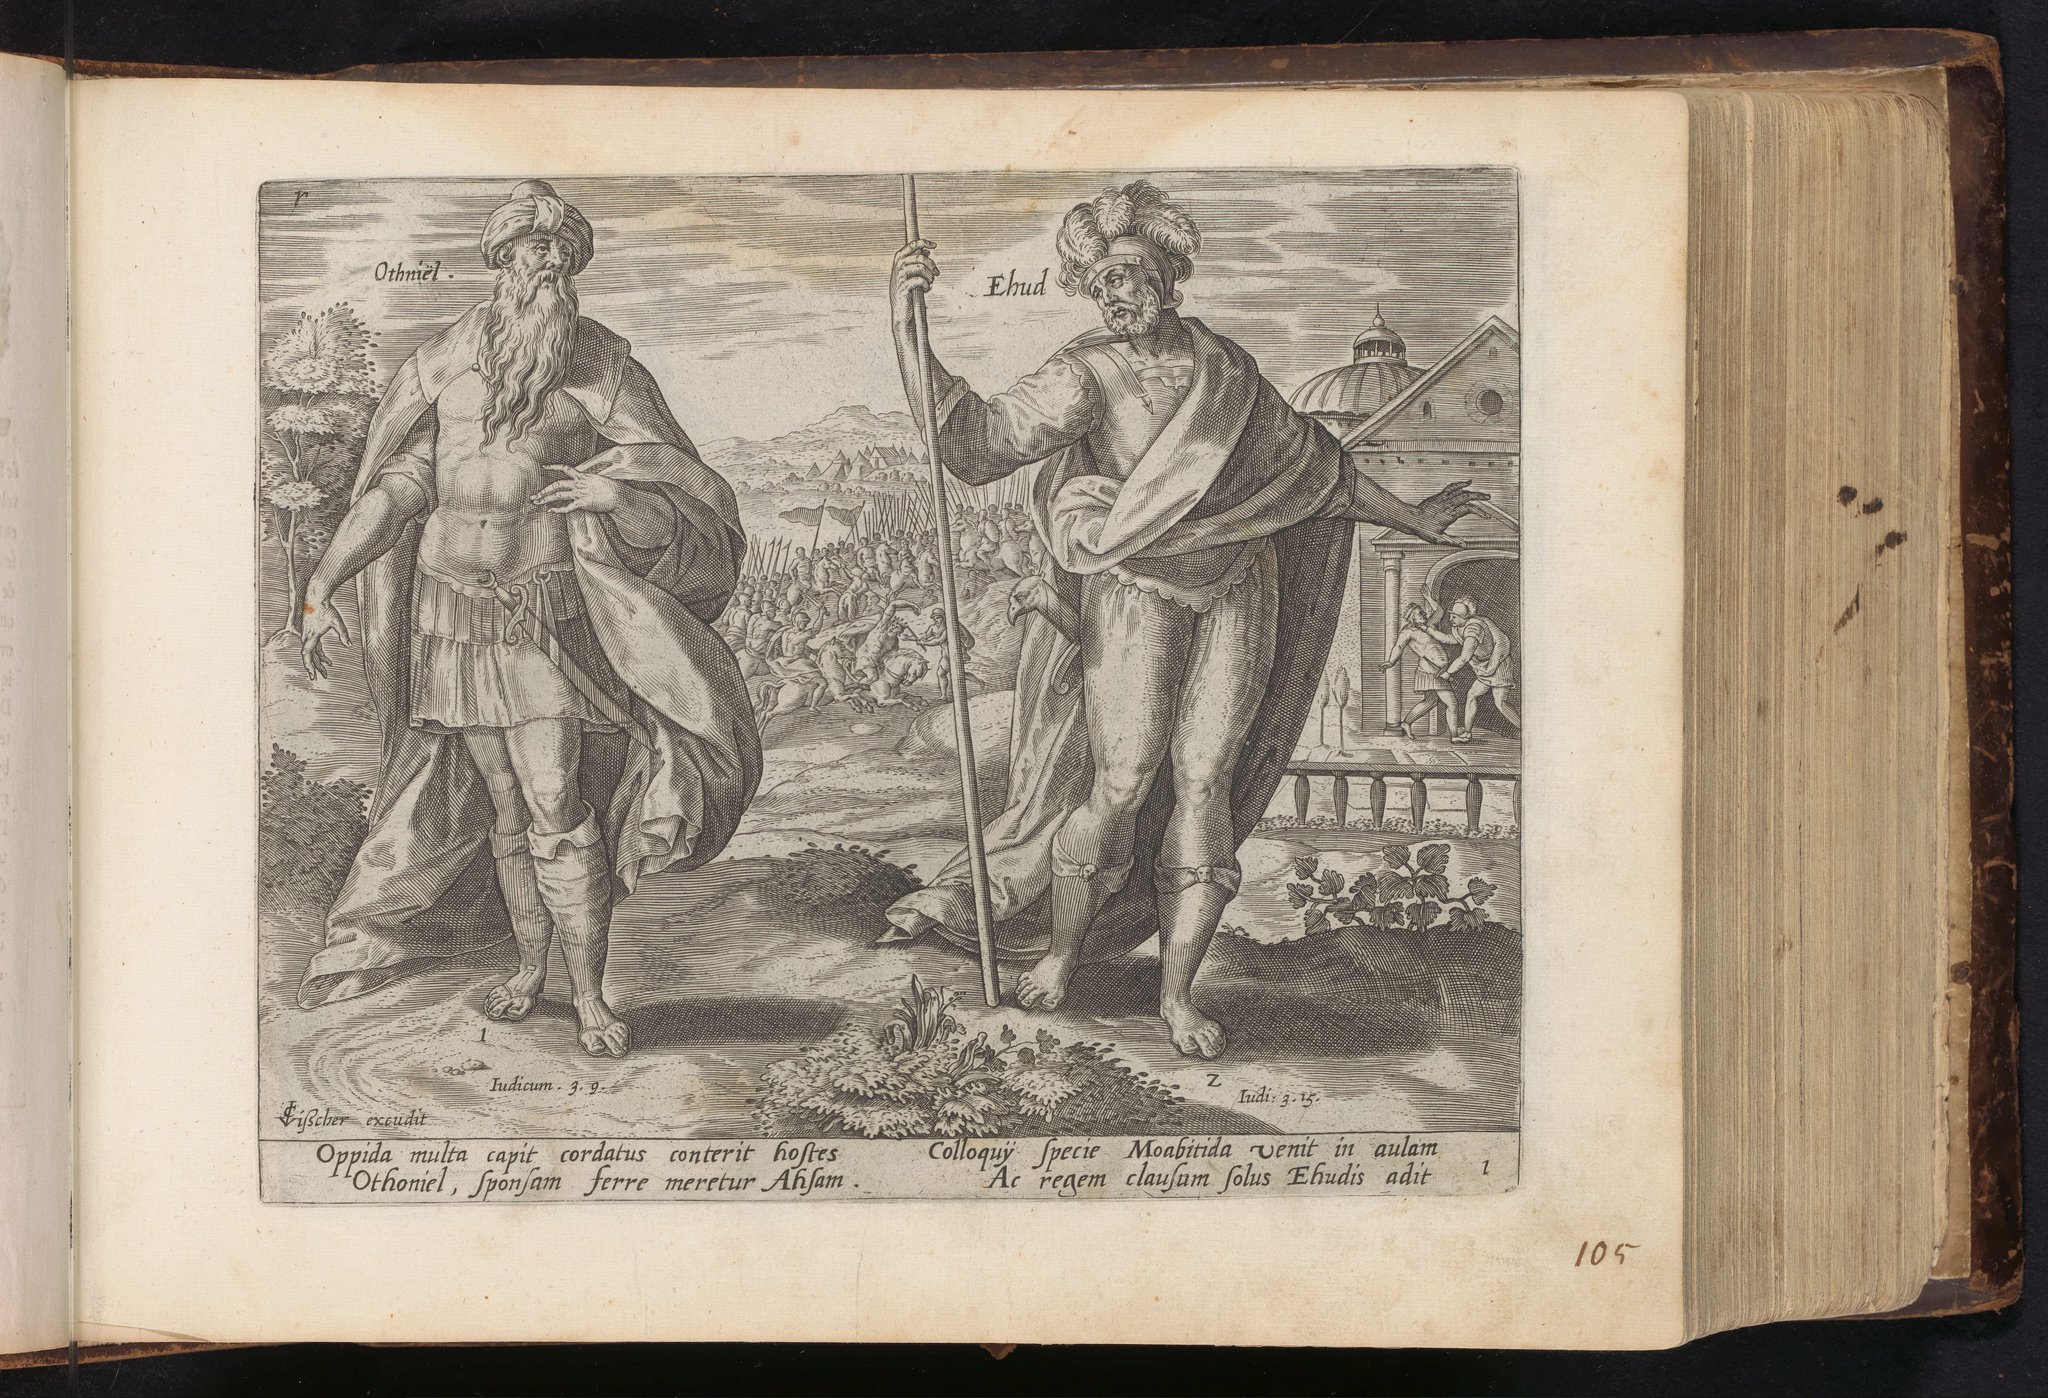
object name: album leaf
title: Van de Rechteren Israels die na Iosua geregeert hebben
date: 1579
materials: paper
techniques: engraving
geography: alkmaar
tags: the left-handed ehud stabs the fat eglon with a dagger in the belly and kills him, othniel conquers debir, and receives caleb's daughter achsah to wife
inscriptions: number: ‘105’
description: De rechters Otniël en Ehud. Op de achtergrond verovert Otniël de stad Debir. Onder de voorstelling van Otniël een verwijzing naar de Bijbeltekst in Re. 3:9 en een verklarende tekst in het Latijn, waarin staat dat hij voor deze overwinning Achsa als vrouw kreeg. Rechts op de achtergrond doodt Ehud koning Eglon van Moab door hem een zwaard in de buik te steken. Onder de voorstelling van Ehud eveneens een verklarende tekst in het Latijn en een verwijzing naar de Bijbeltekst in Ri. 3:15. Deze prent maakt deel uit van een album.